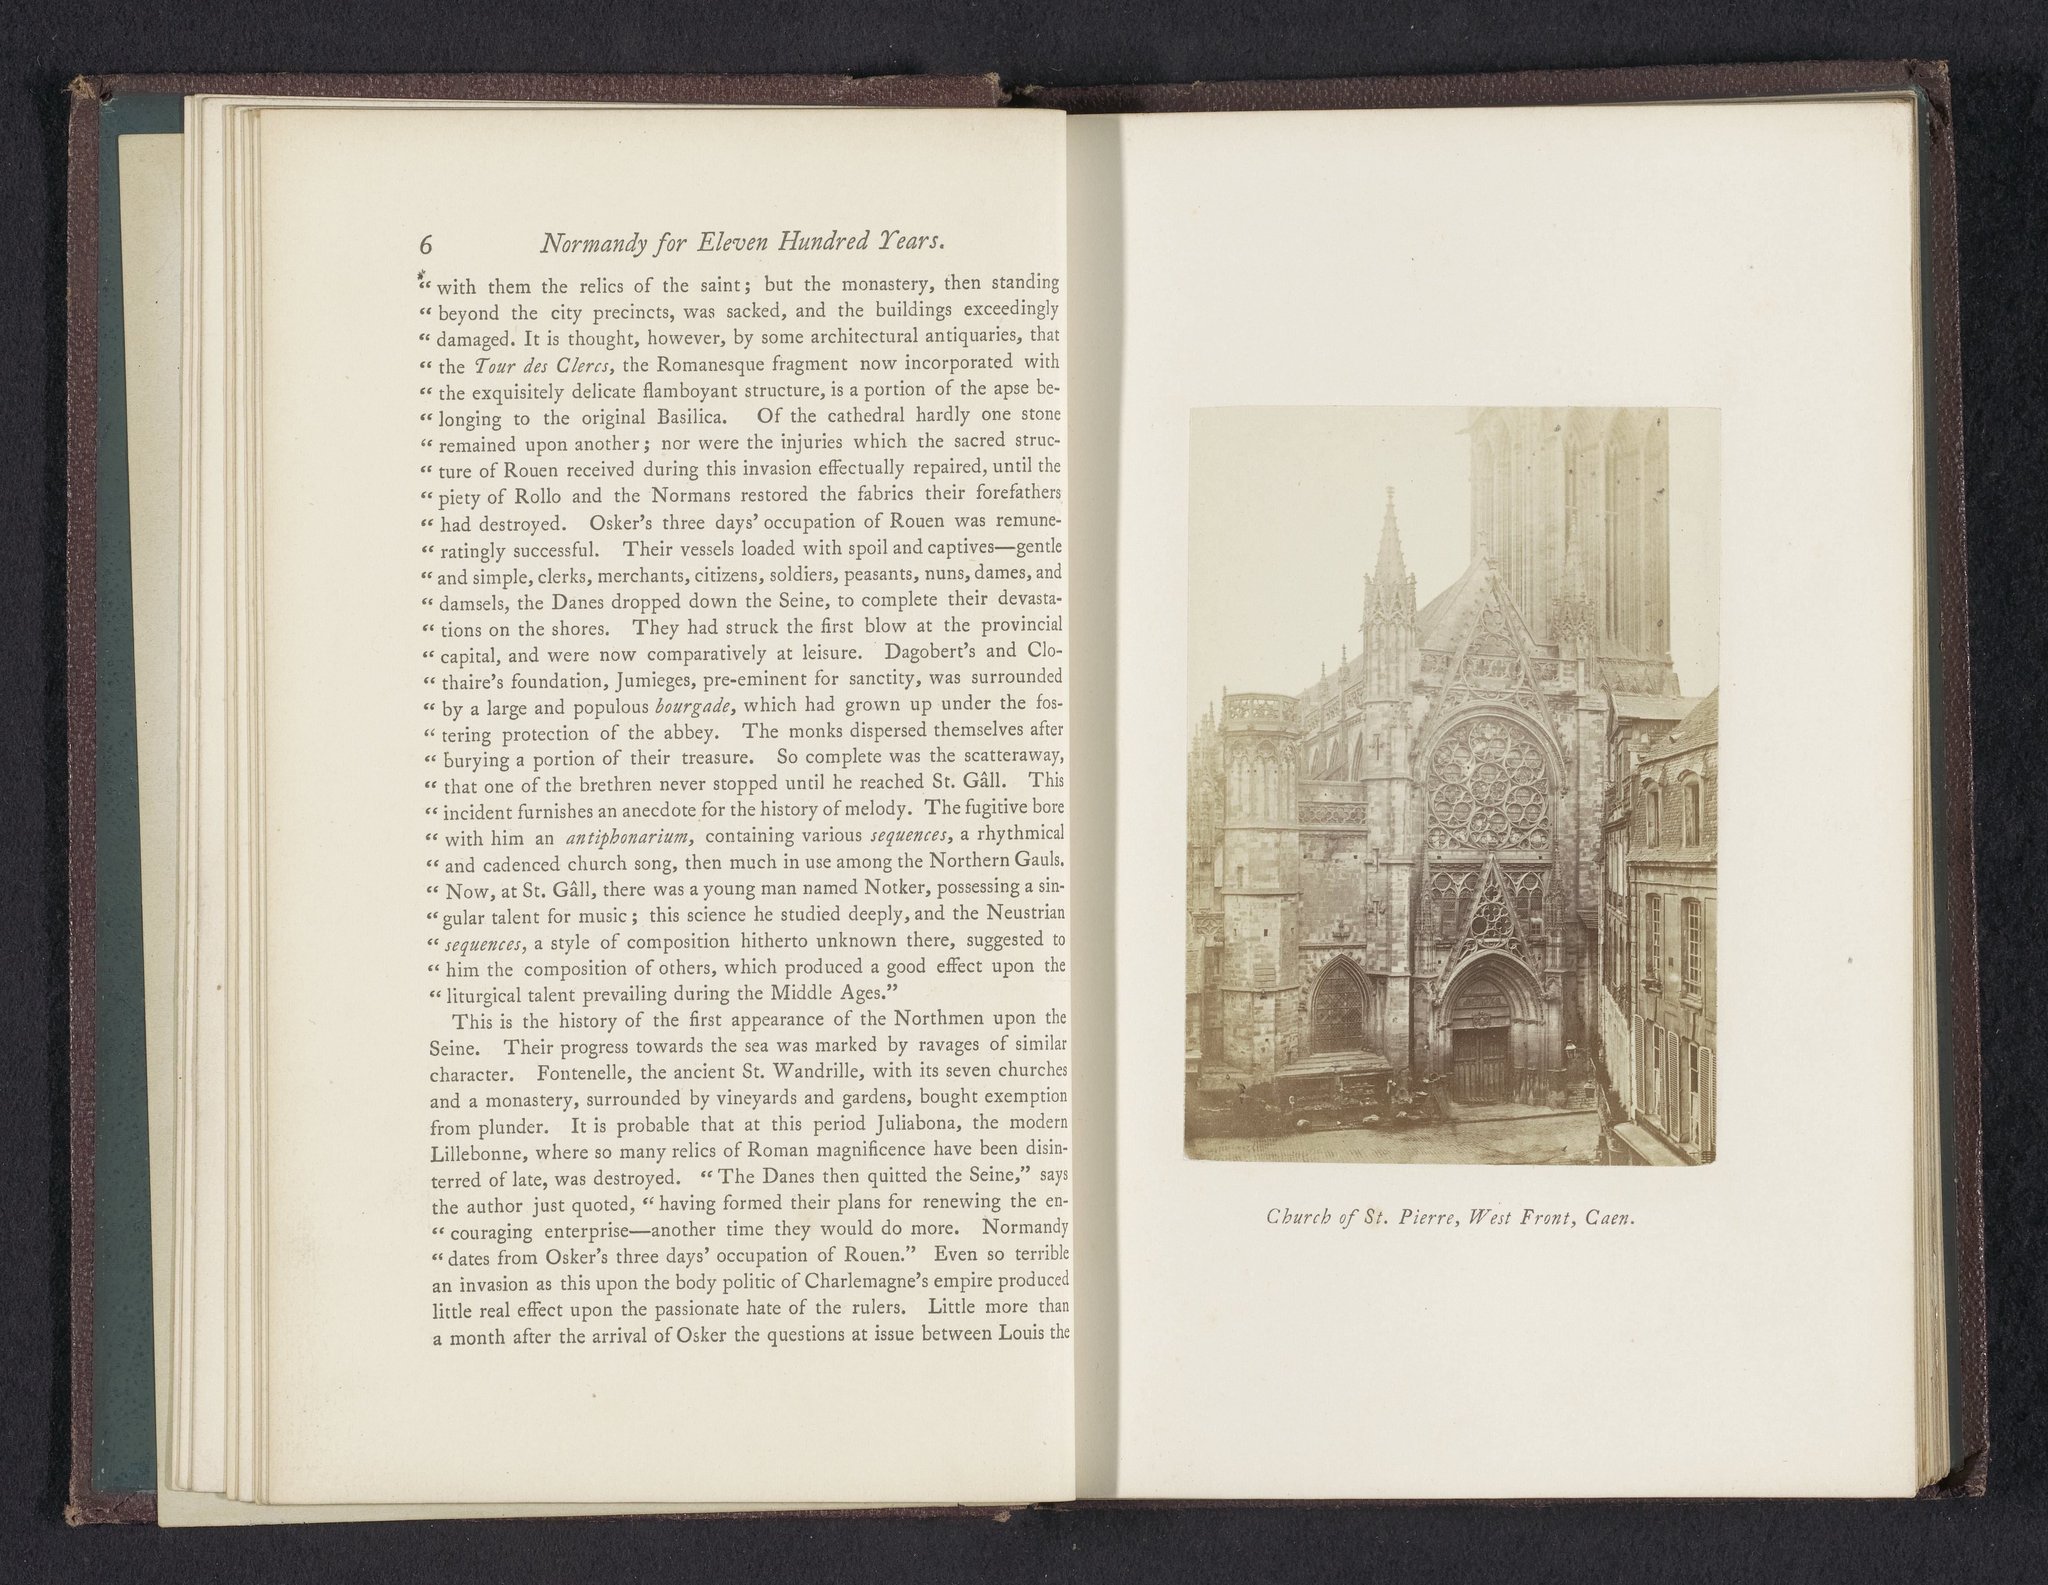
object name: photograph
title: Church of St. Pierre, west front, Caen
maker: joseph cundall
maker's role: fotograaf, schrijver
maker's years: 1818-1895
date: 1855-1865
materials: photographic support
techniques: albumen print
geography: caen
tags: parts of church exterior and annexes: portal, façade (of house or building)